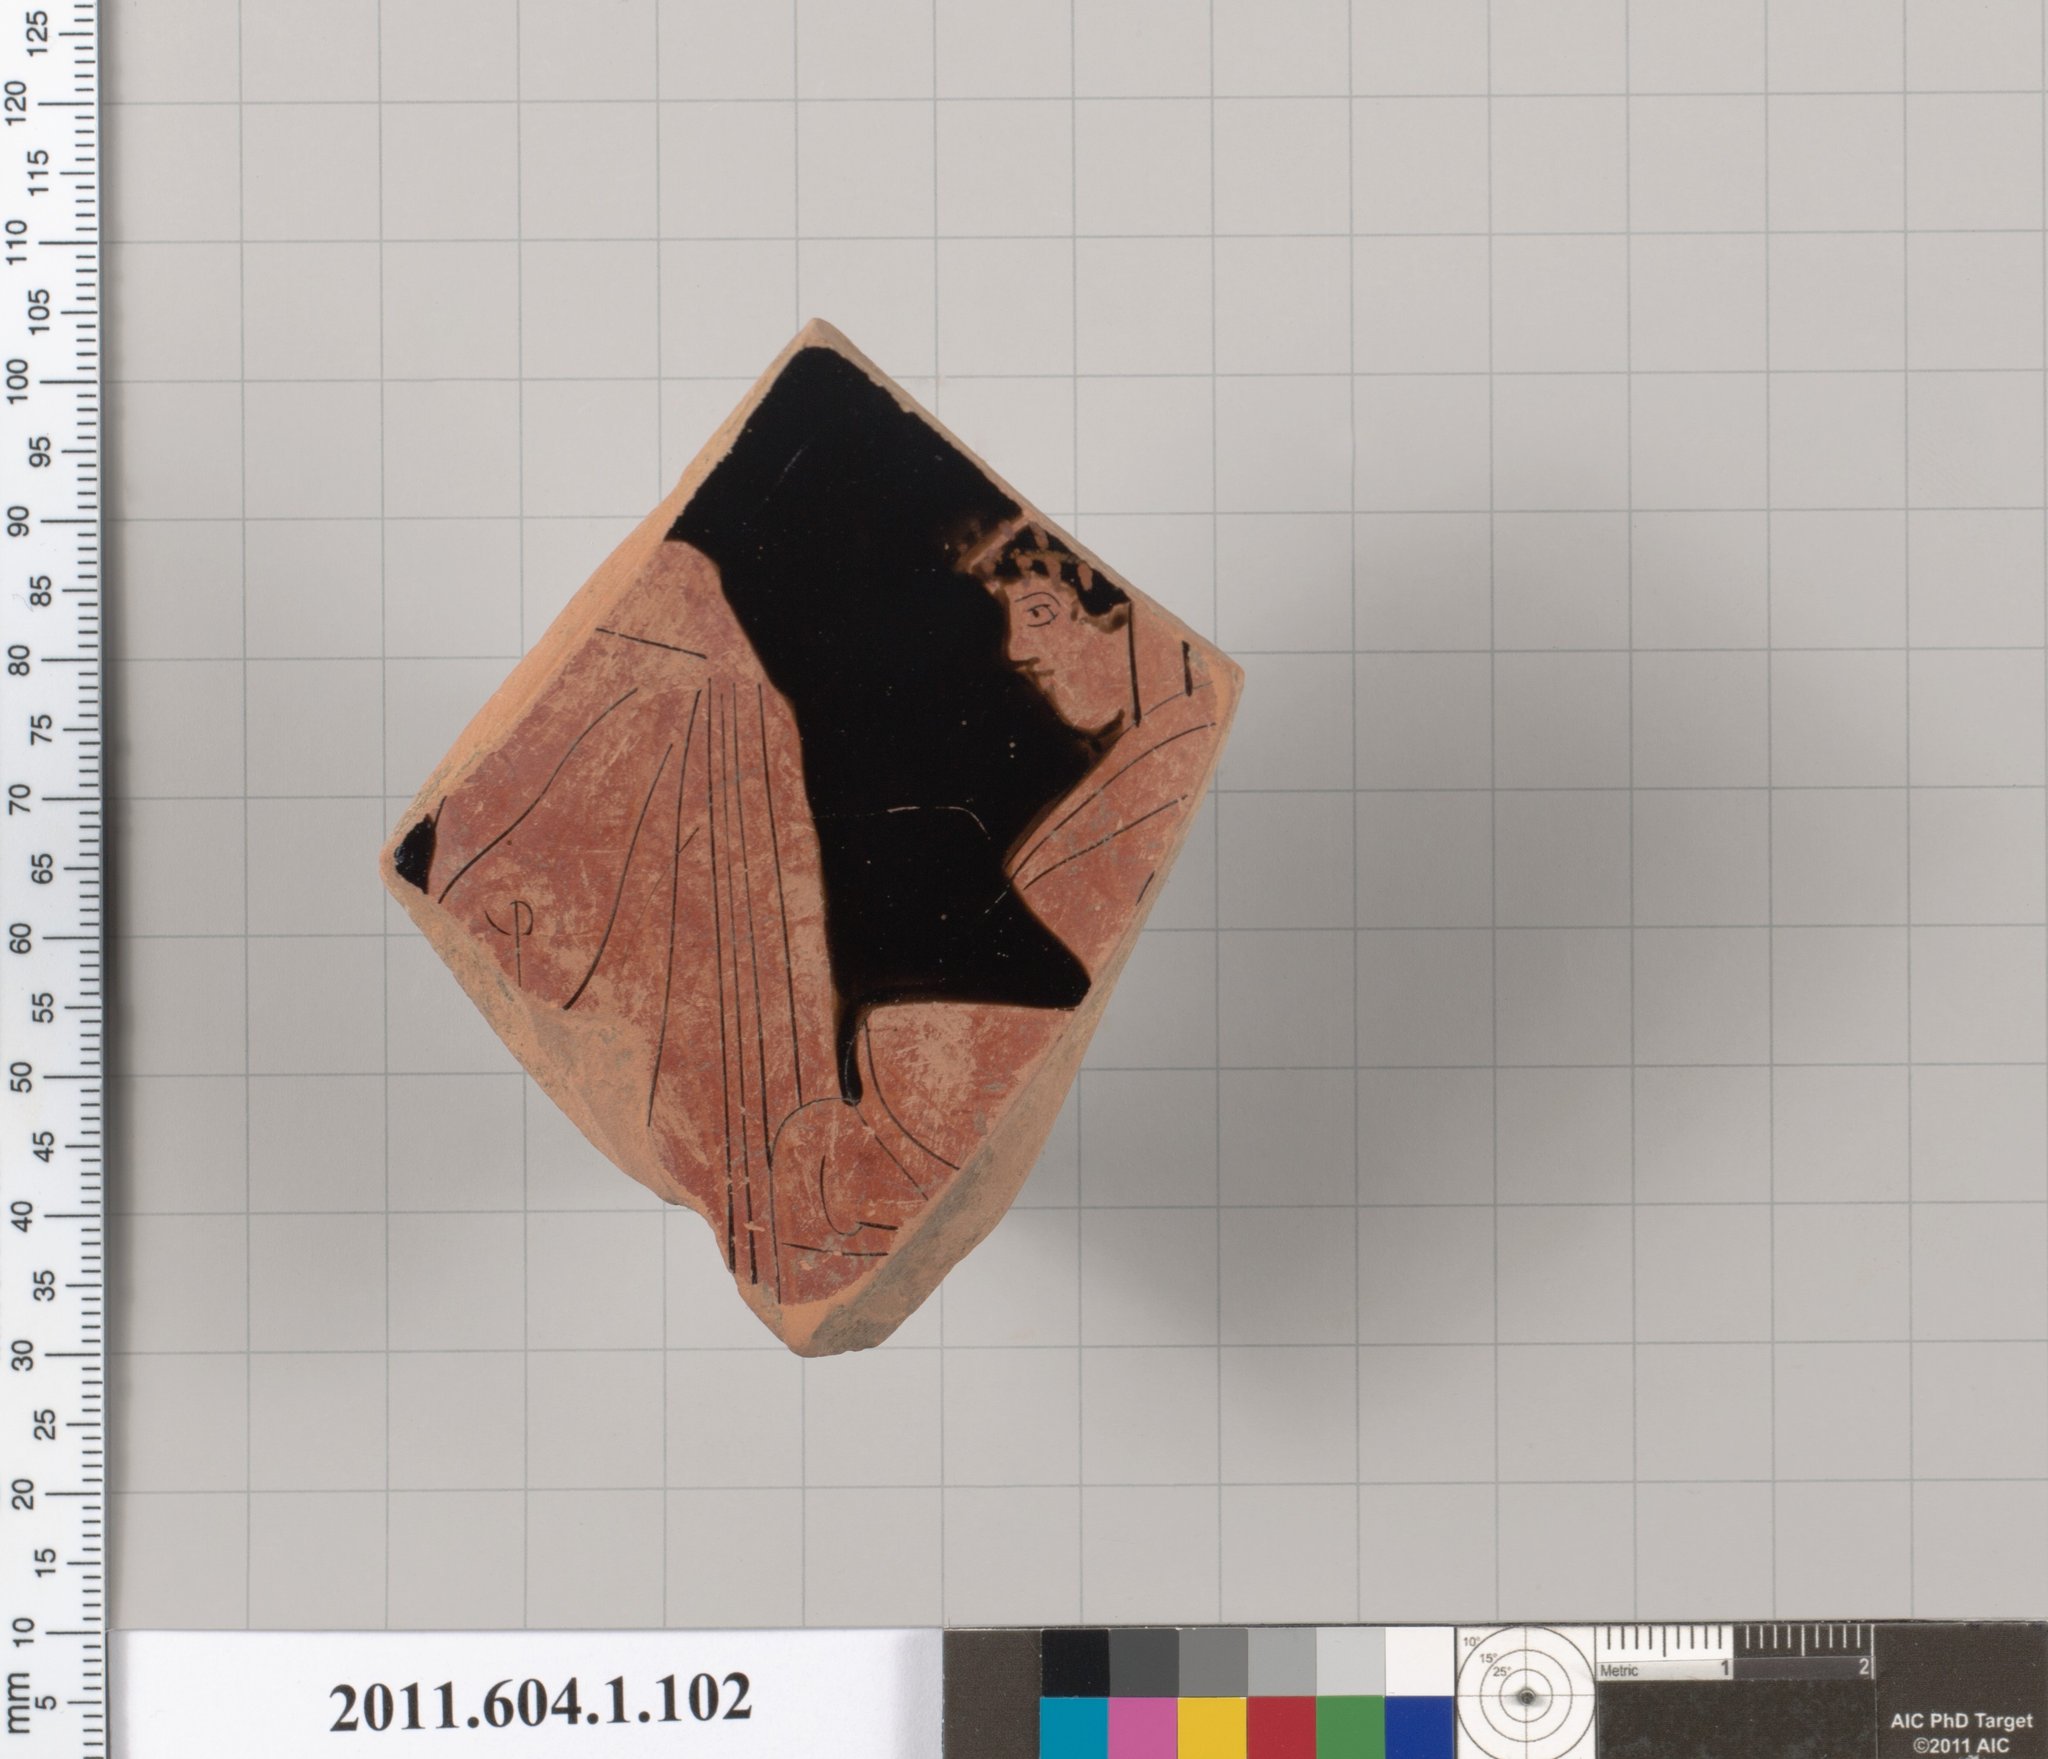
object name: kylix fragment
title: Terracotta fragment of a kylix (drinking cup)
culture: greek, attic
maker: splanchnopt painter?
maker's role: artist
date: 470-450 BCE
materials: terracotta